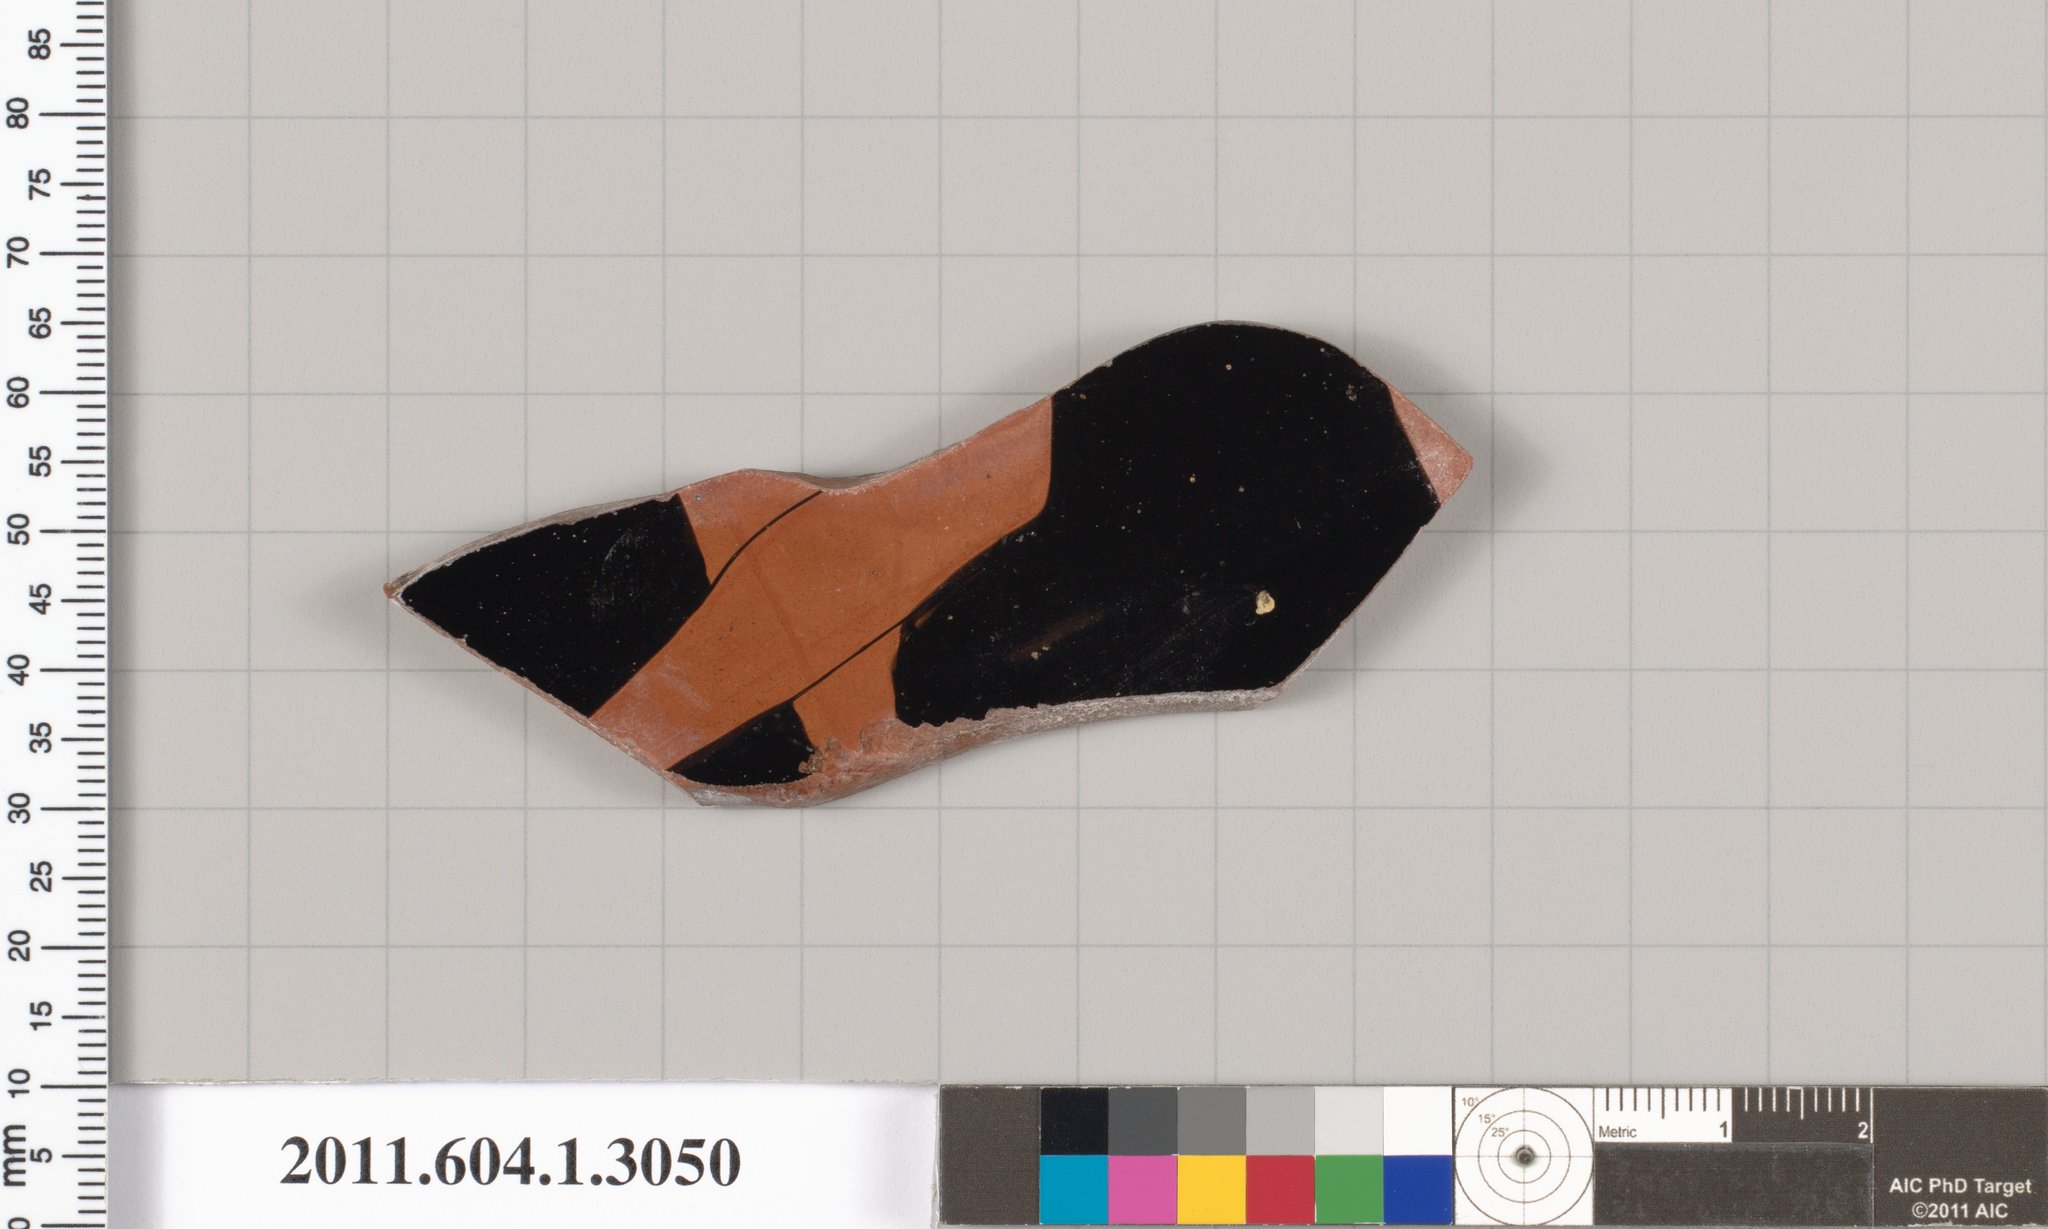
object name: kylix fragment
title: Terracotta fragment of a kylix (drinking cup)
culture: greek, attic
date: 490-480 BCE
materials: terracotta